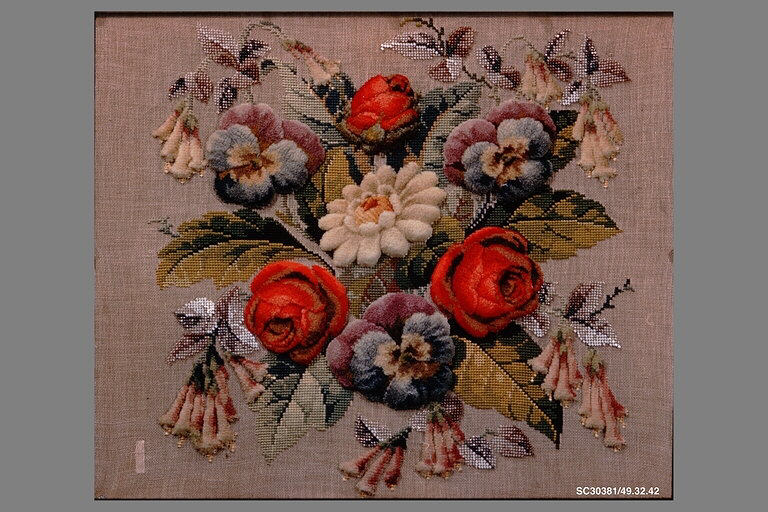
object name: cushion cover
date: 1834-1866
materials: canvas, glass, paste, wool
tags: roses